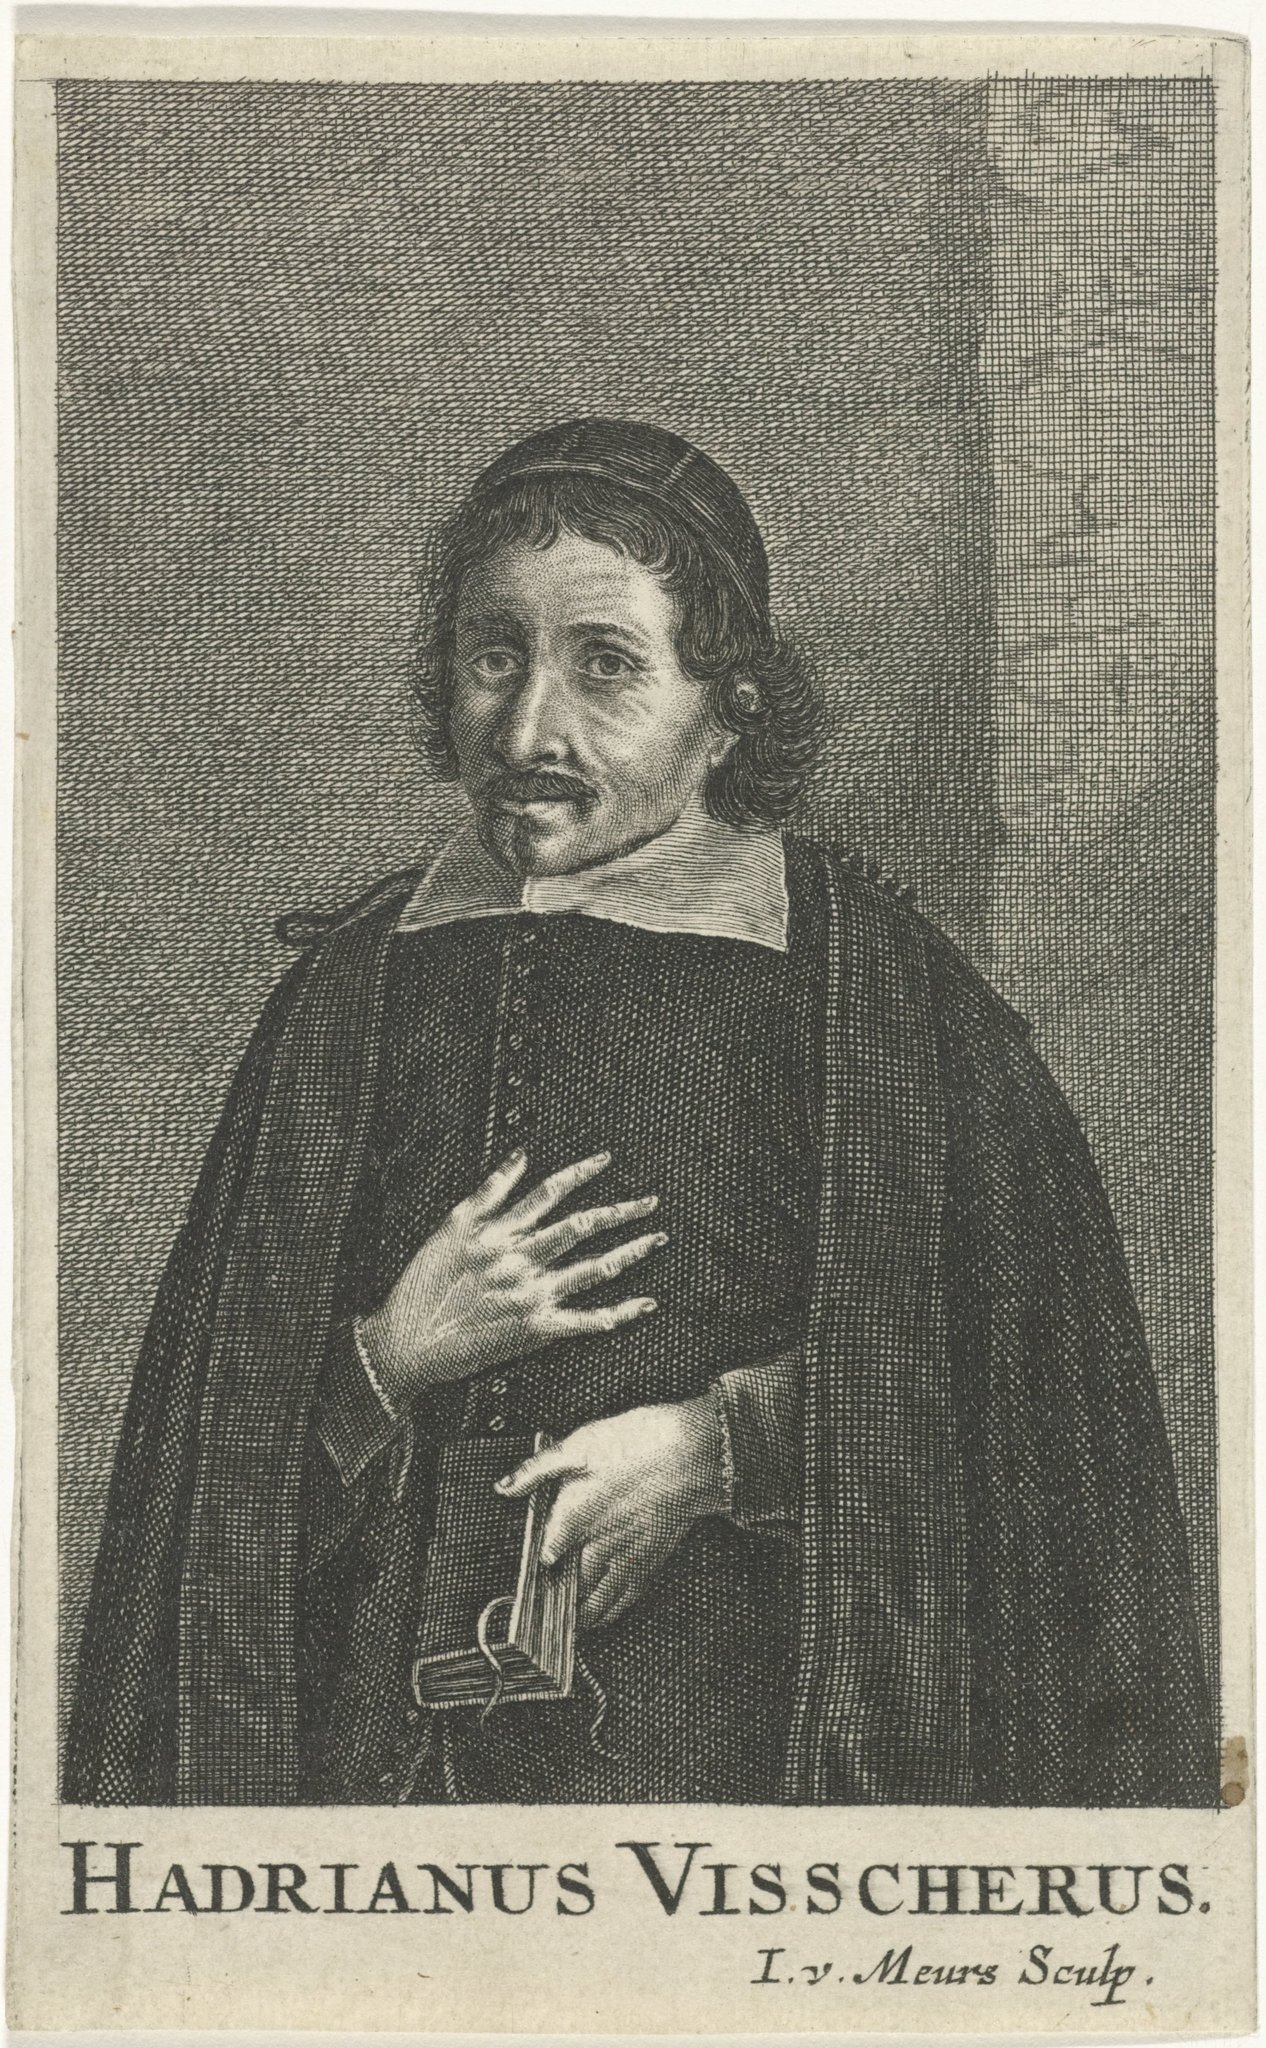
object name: print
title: Portret van Hadrianus Visscherus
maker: jacob van meurs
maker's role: draughtsman, print maker, publisher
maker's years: 1619-1680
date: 1630-1680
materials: paper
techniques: engraving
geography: northern netherlands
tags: predikant, hadrianus visscherus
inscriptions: collector's mark: Lugt 2228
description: Portret van Hadrianus Visscherus, predikant en schrijver.